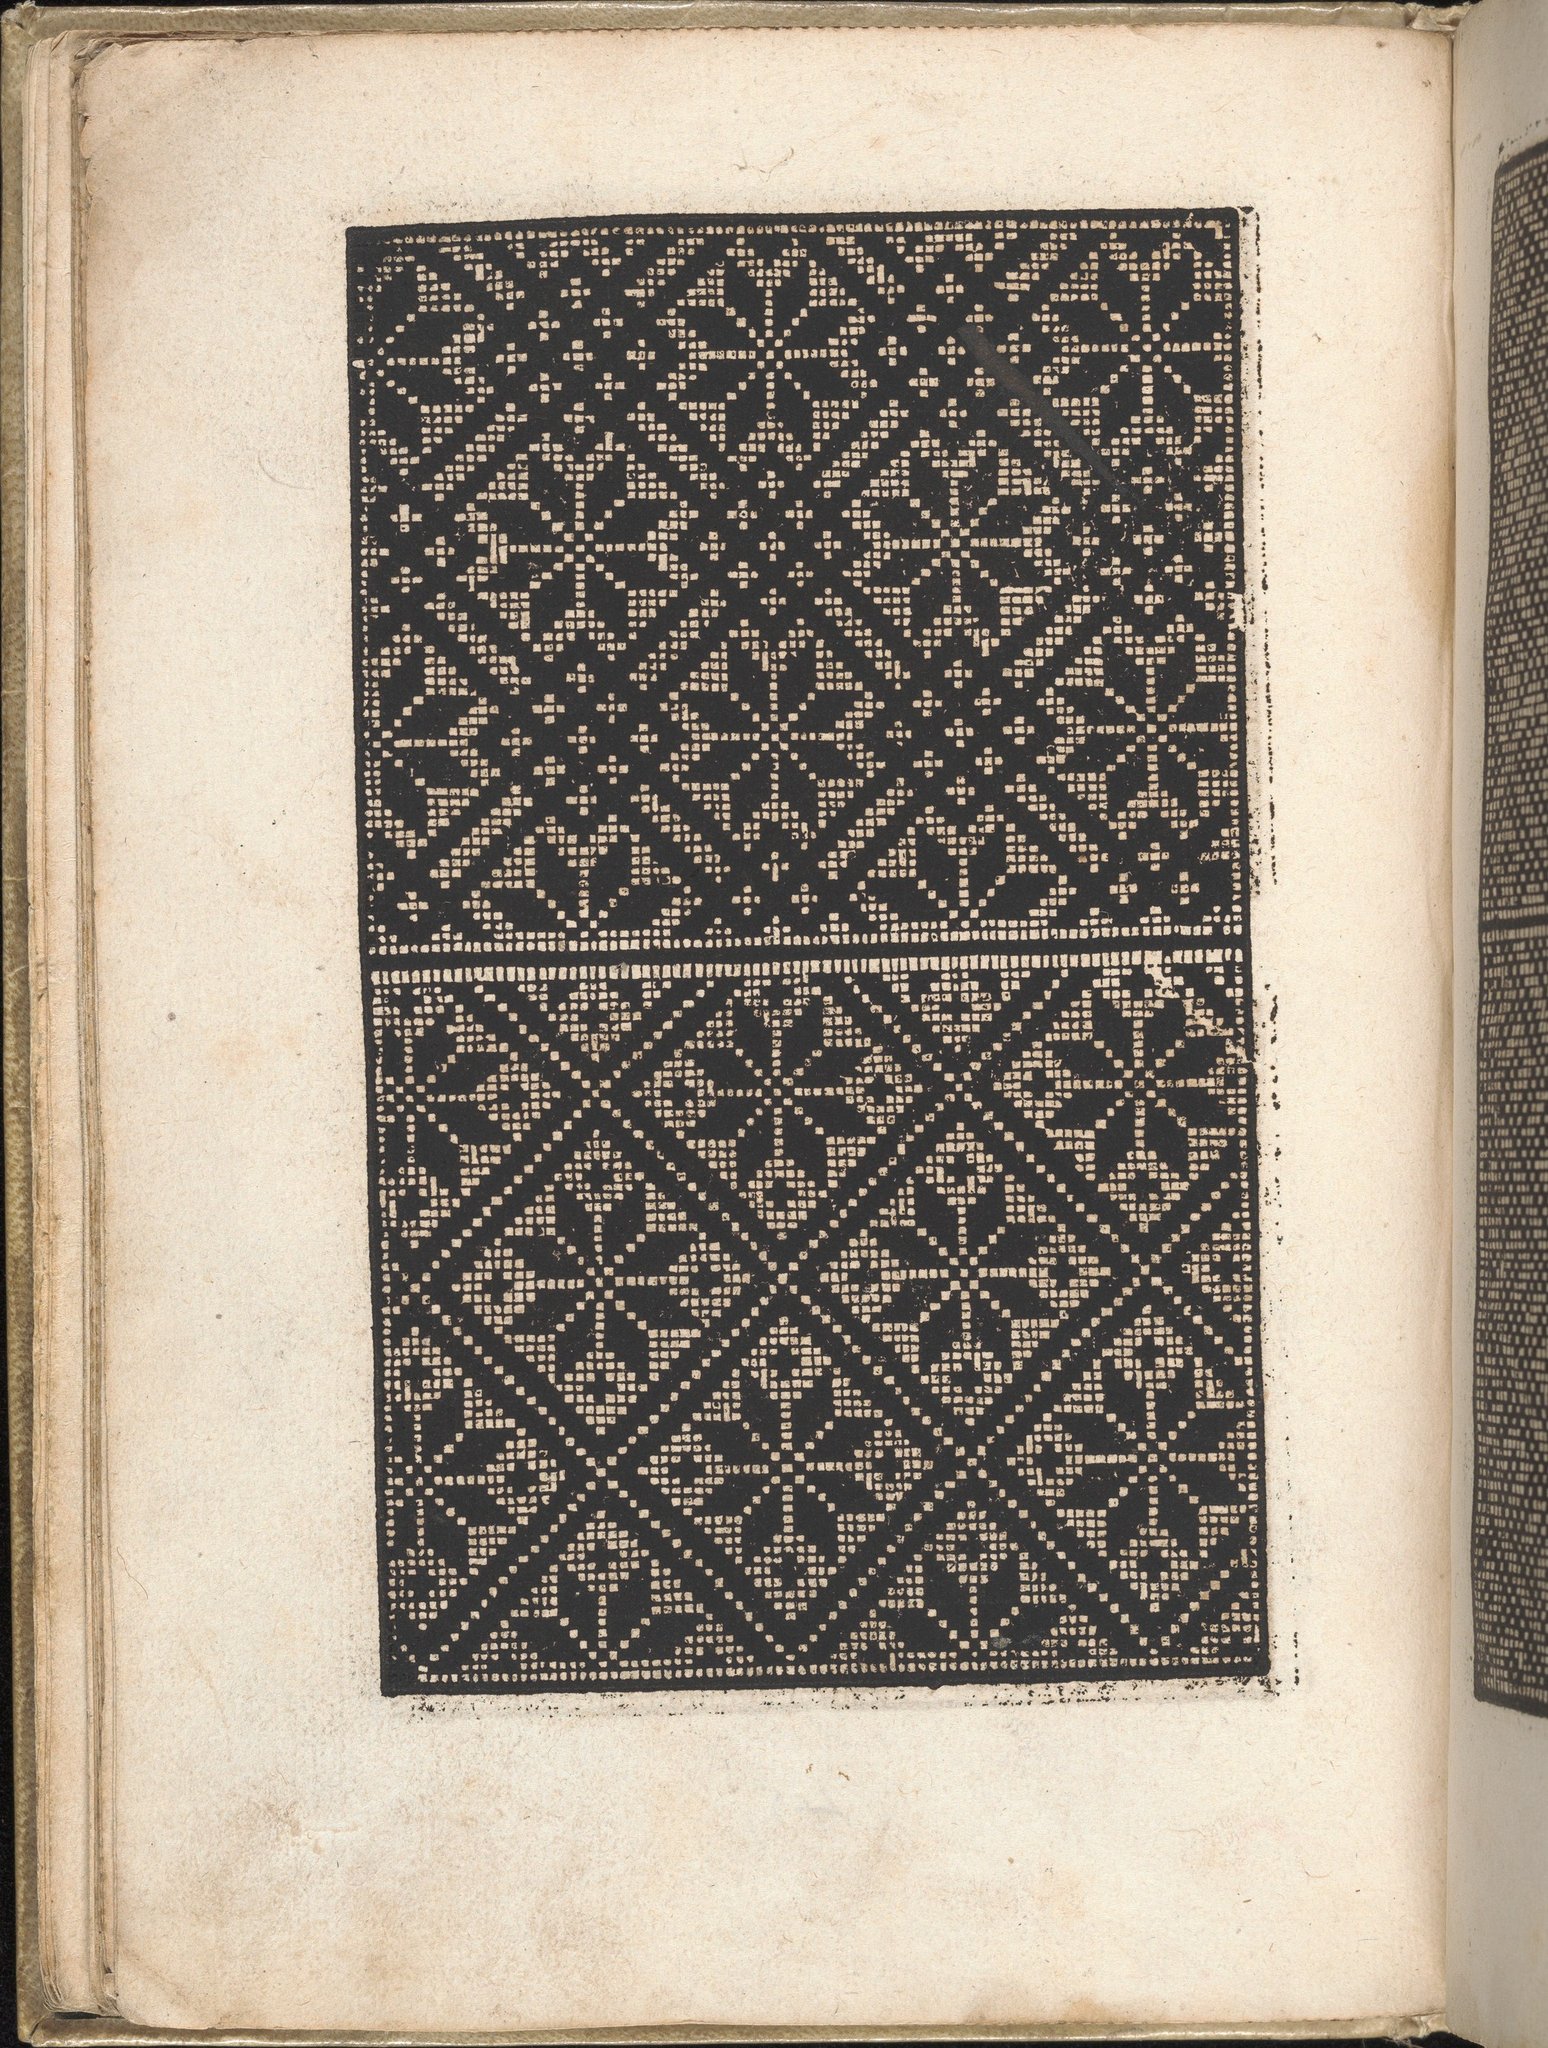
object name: book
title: Page 20r, from "Eyn New Kunstlichboich"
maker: peter quentel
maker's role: publisher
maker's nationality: german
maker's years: 1500-1550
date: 1529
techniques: woodcut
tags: ornament